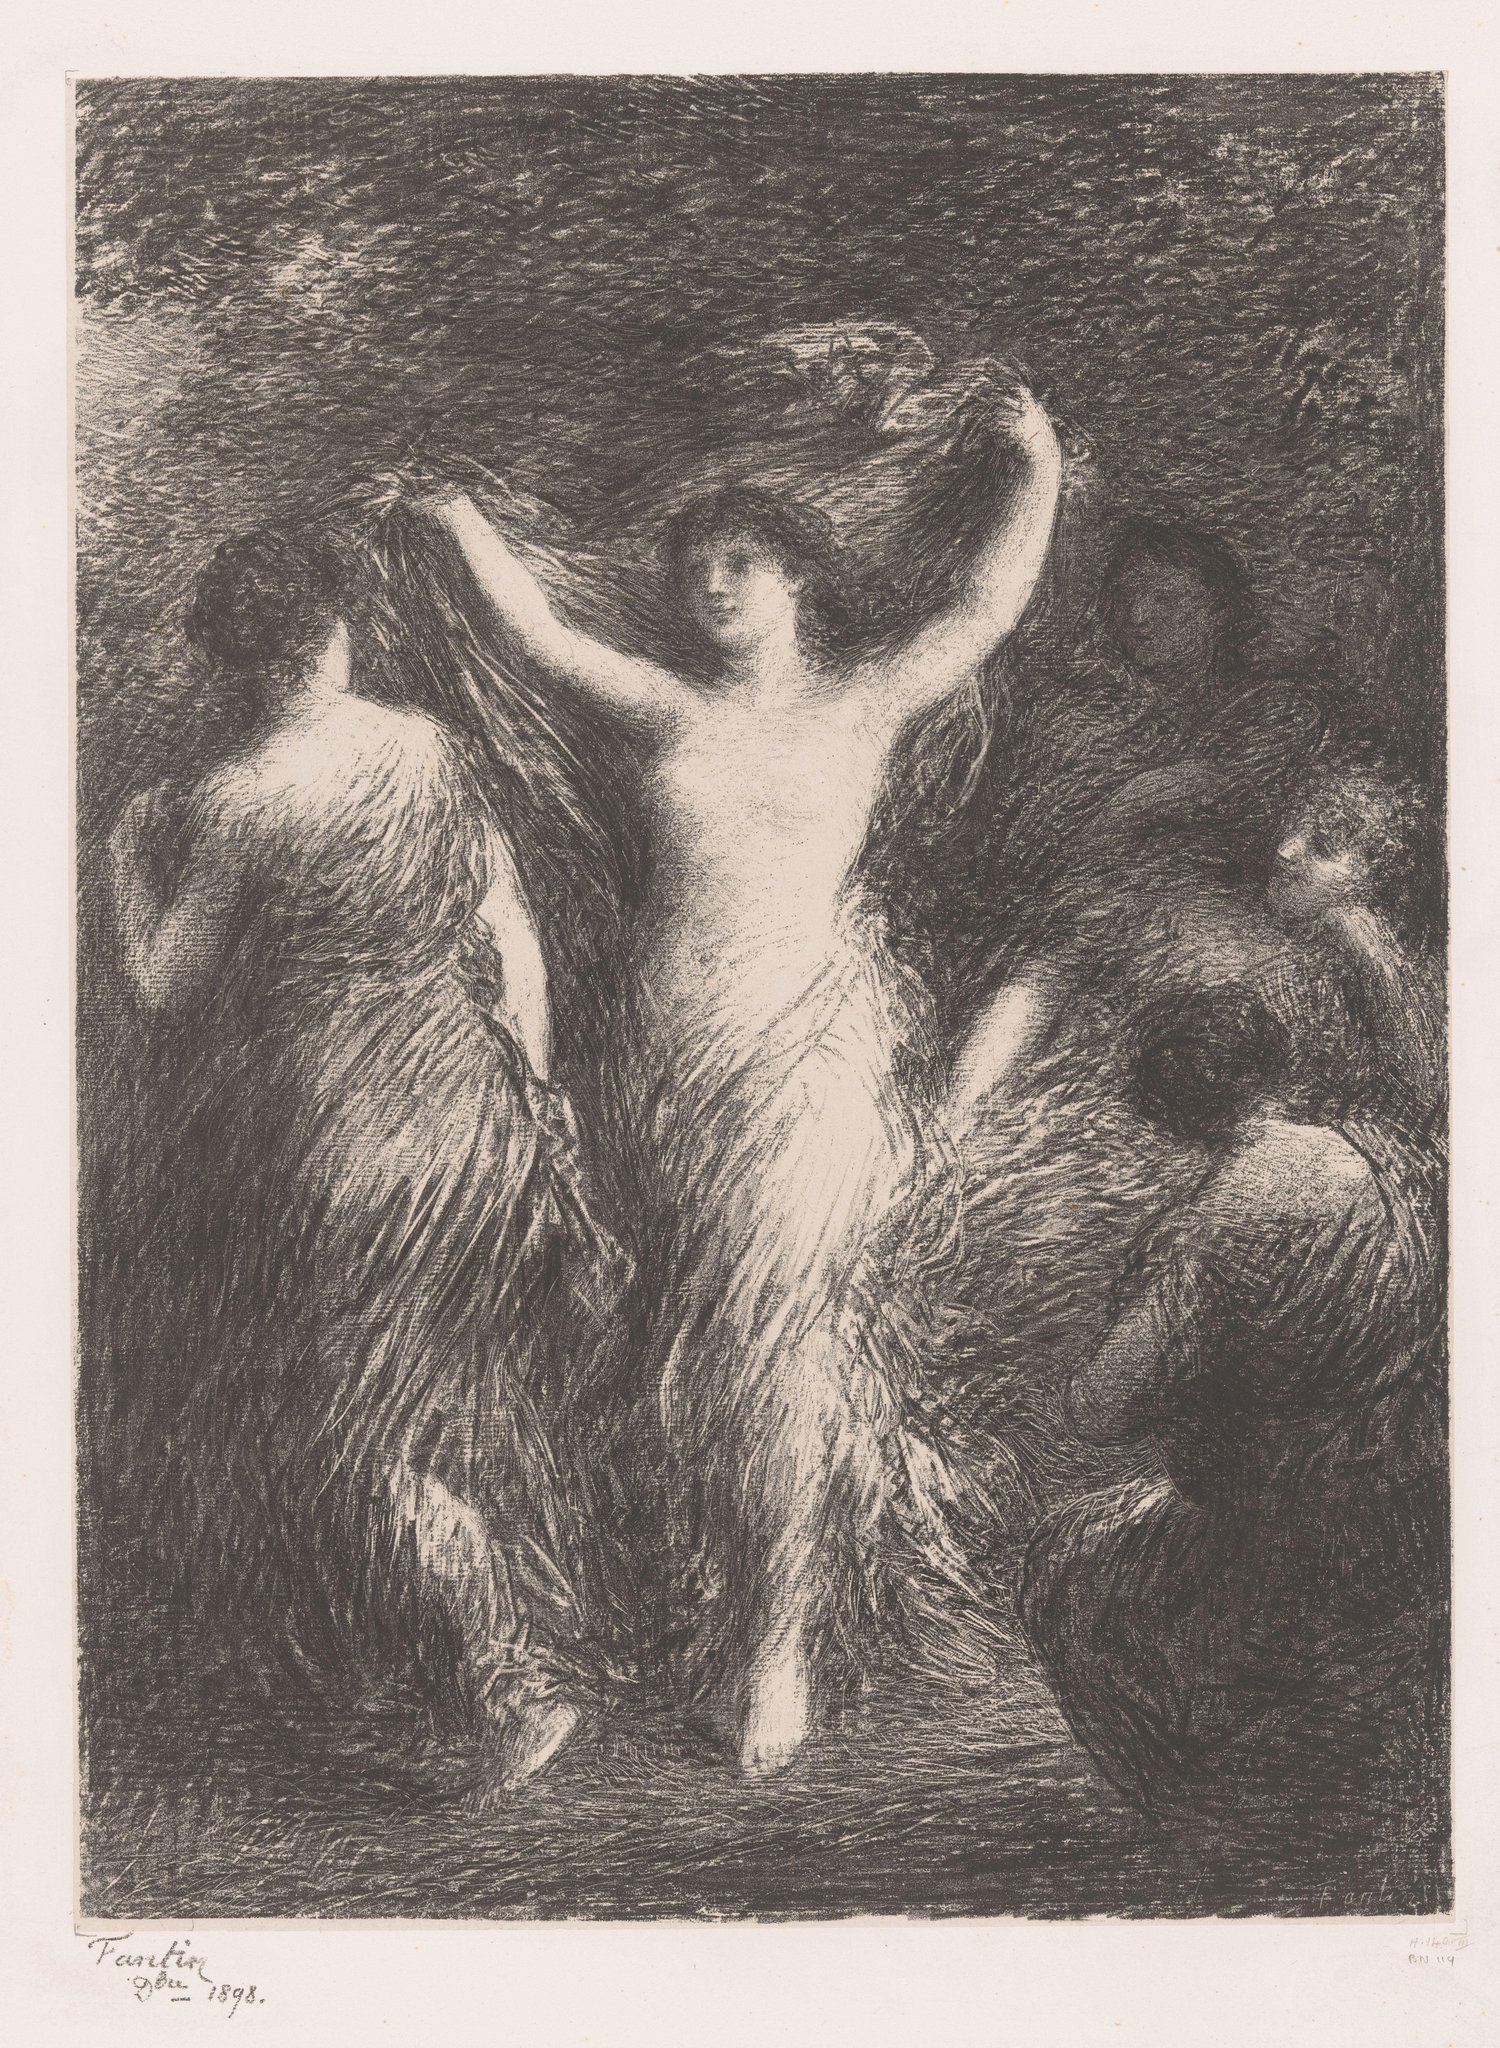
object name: print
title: Dansende en toekijkende vrouwen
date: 1812-1898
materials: paper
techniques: lithography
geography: paris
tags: dancing, woman (showing herself) undressed, quasi-nude, veil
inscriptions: collector's mark: Lugt 2228a